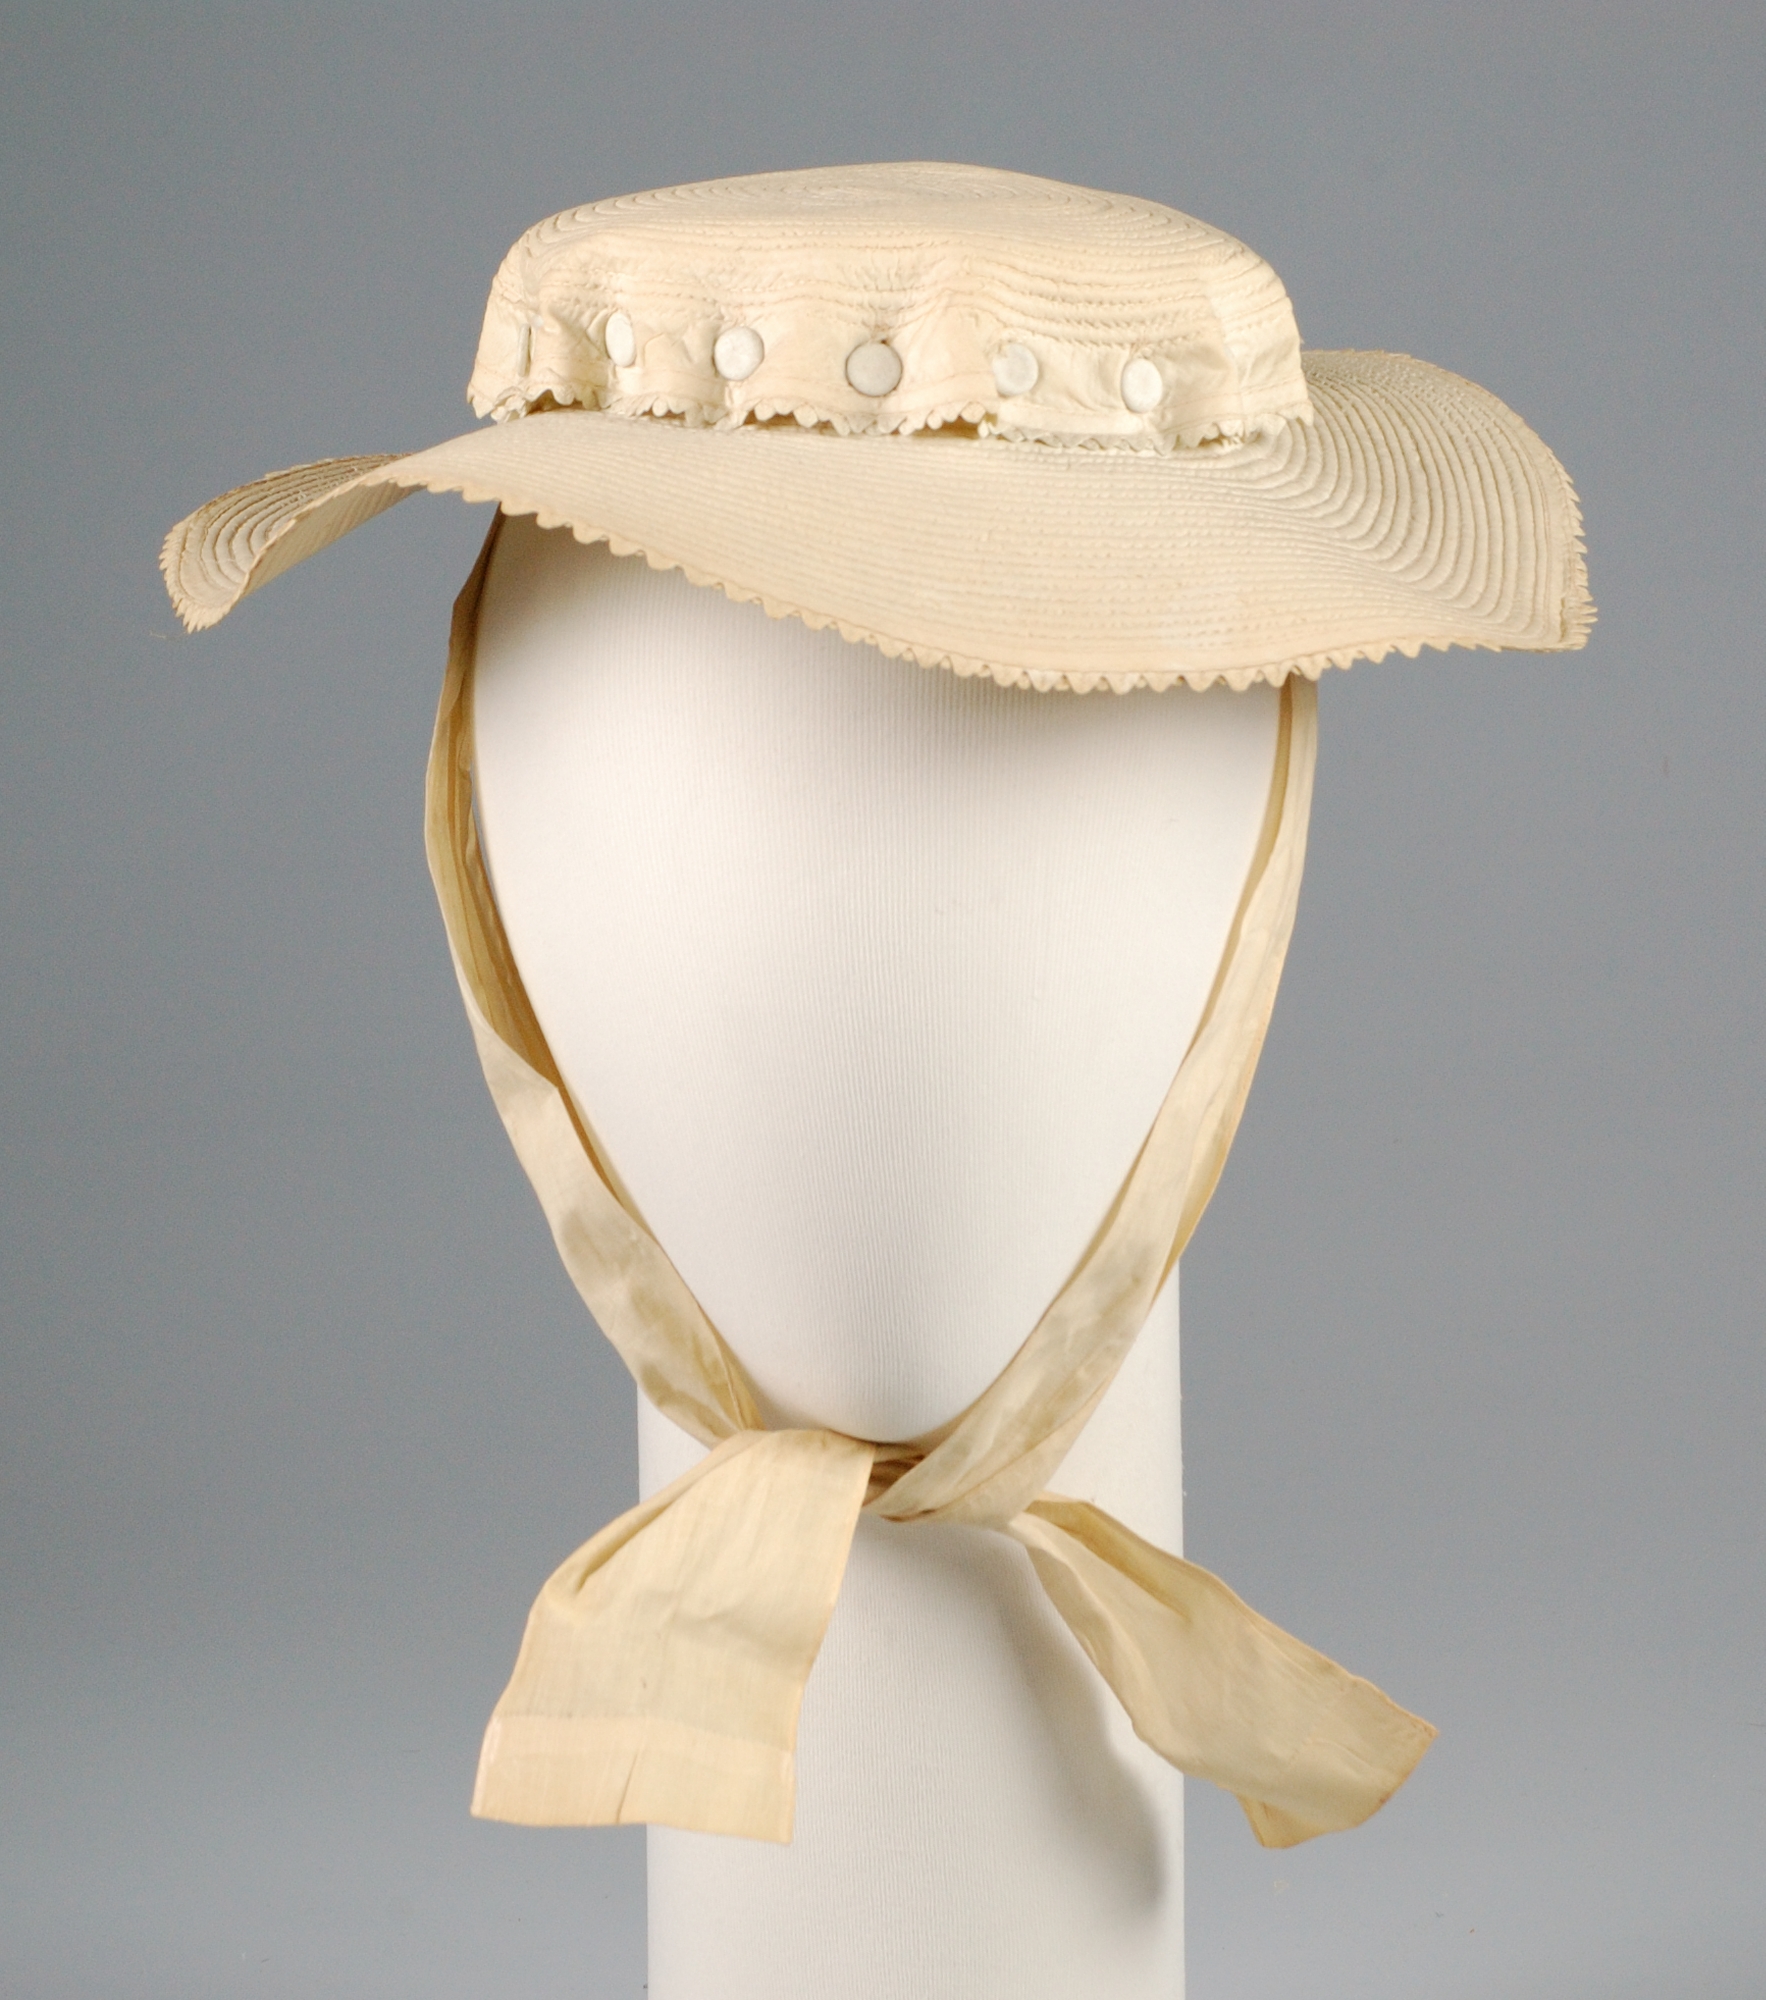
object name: hat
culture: american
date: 1850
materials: cotton